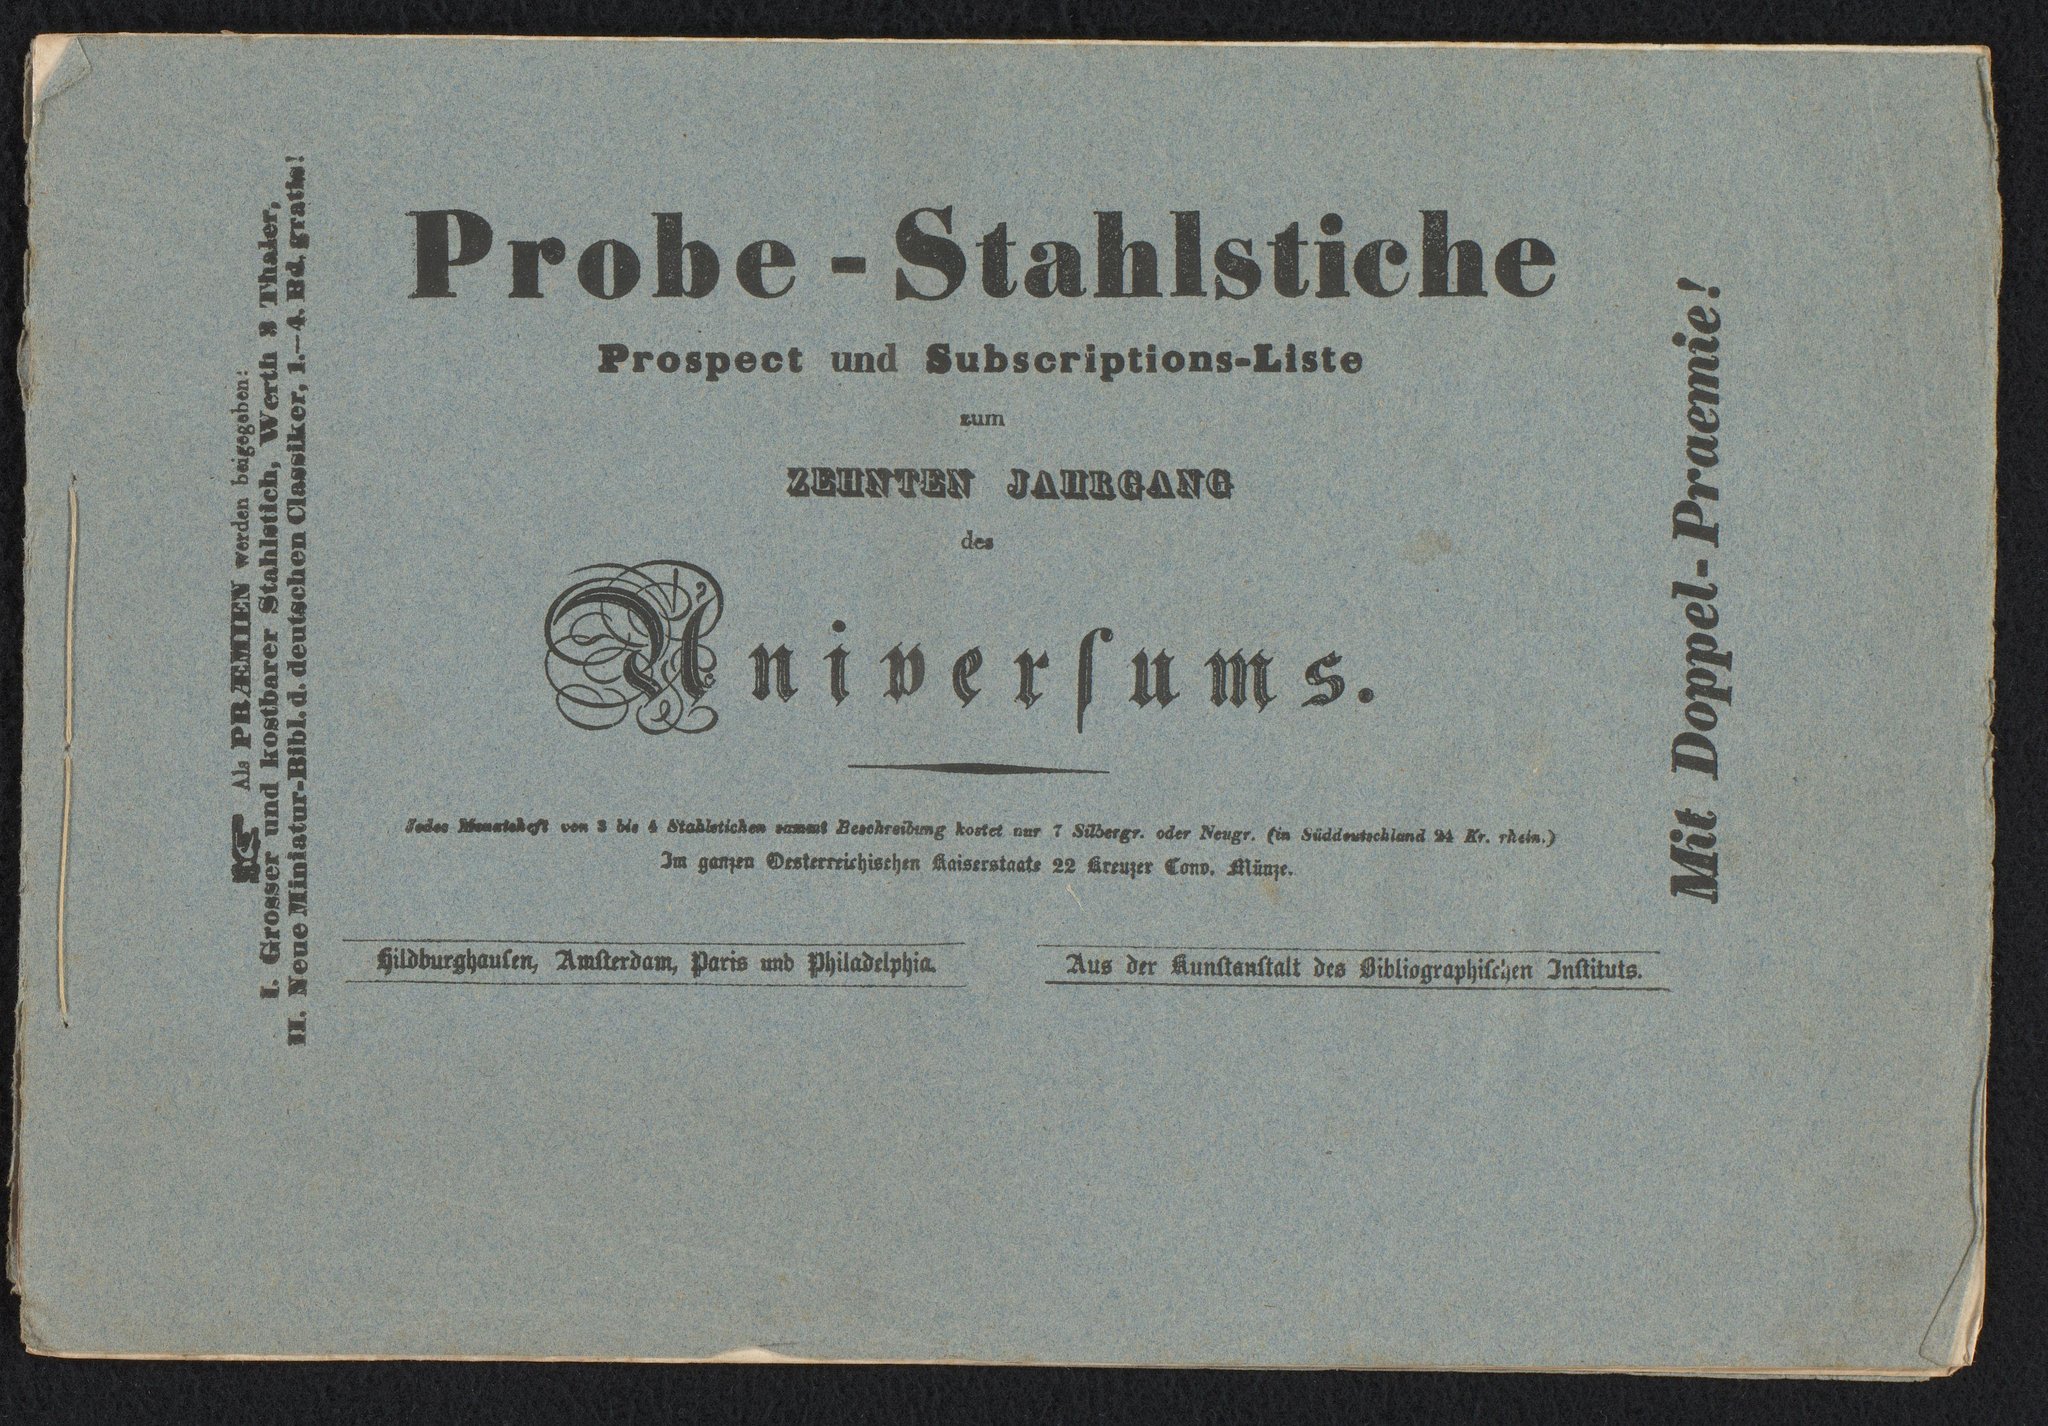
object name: prospectus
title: Prospectus voor het tiende jaargang van Meyer's Universum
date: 1803-1843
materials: paper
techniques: bookbinding, letterpress printing, engraving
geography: hildburghausen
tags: landscapes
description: Prospectus voor: Meyer, Joseph. Meyer's Universum oder die schönsten Ansichten der Erde. Hildburghausen: Bibliographischen Institut, 1834, dl. 10.